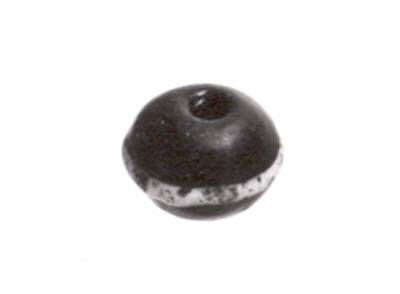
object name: bead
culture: sasanian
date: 201-700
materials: glass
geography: iran